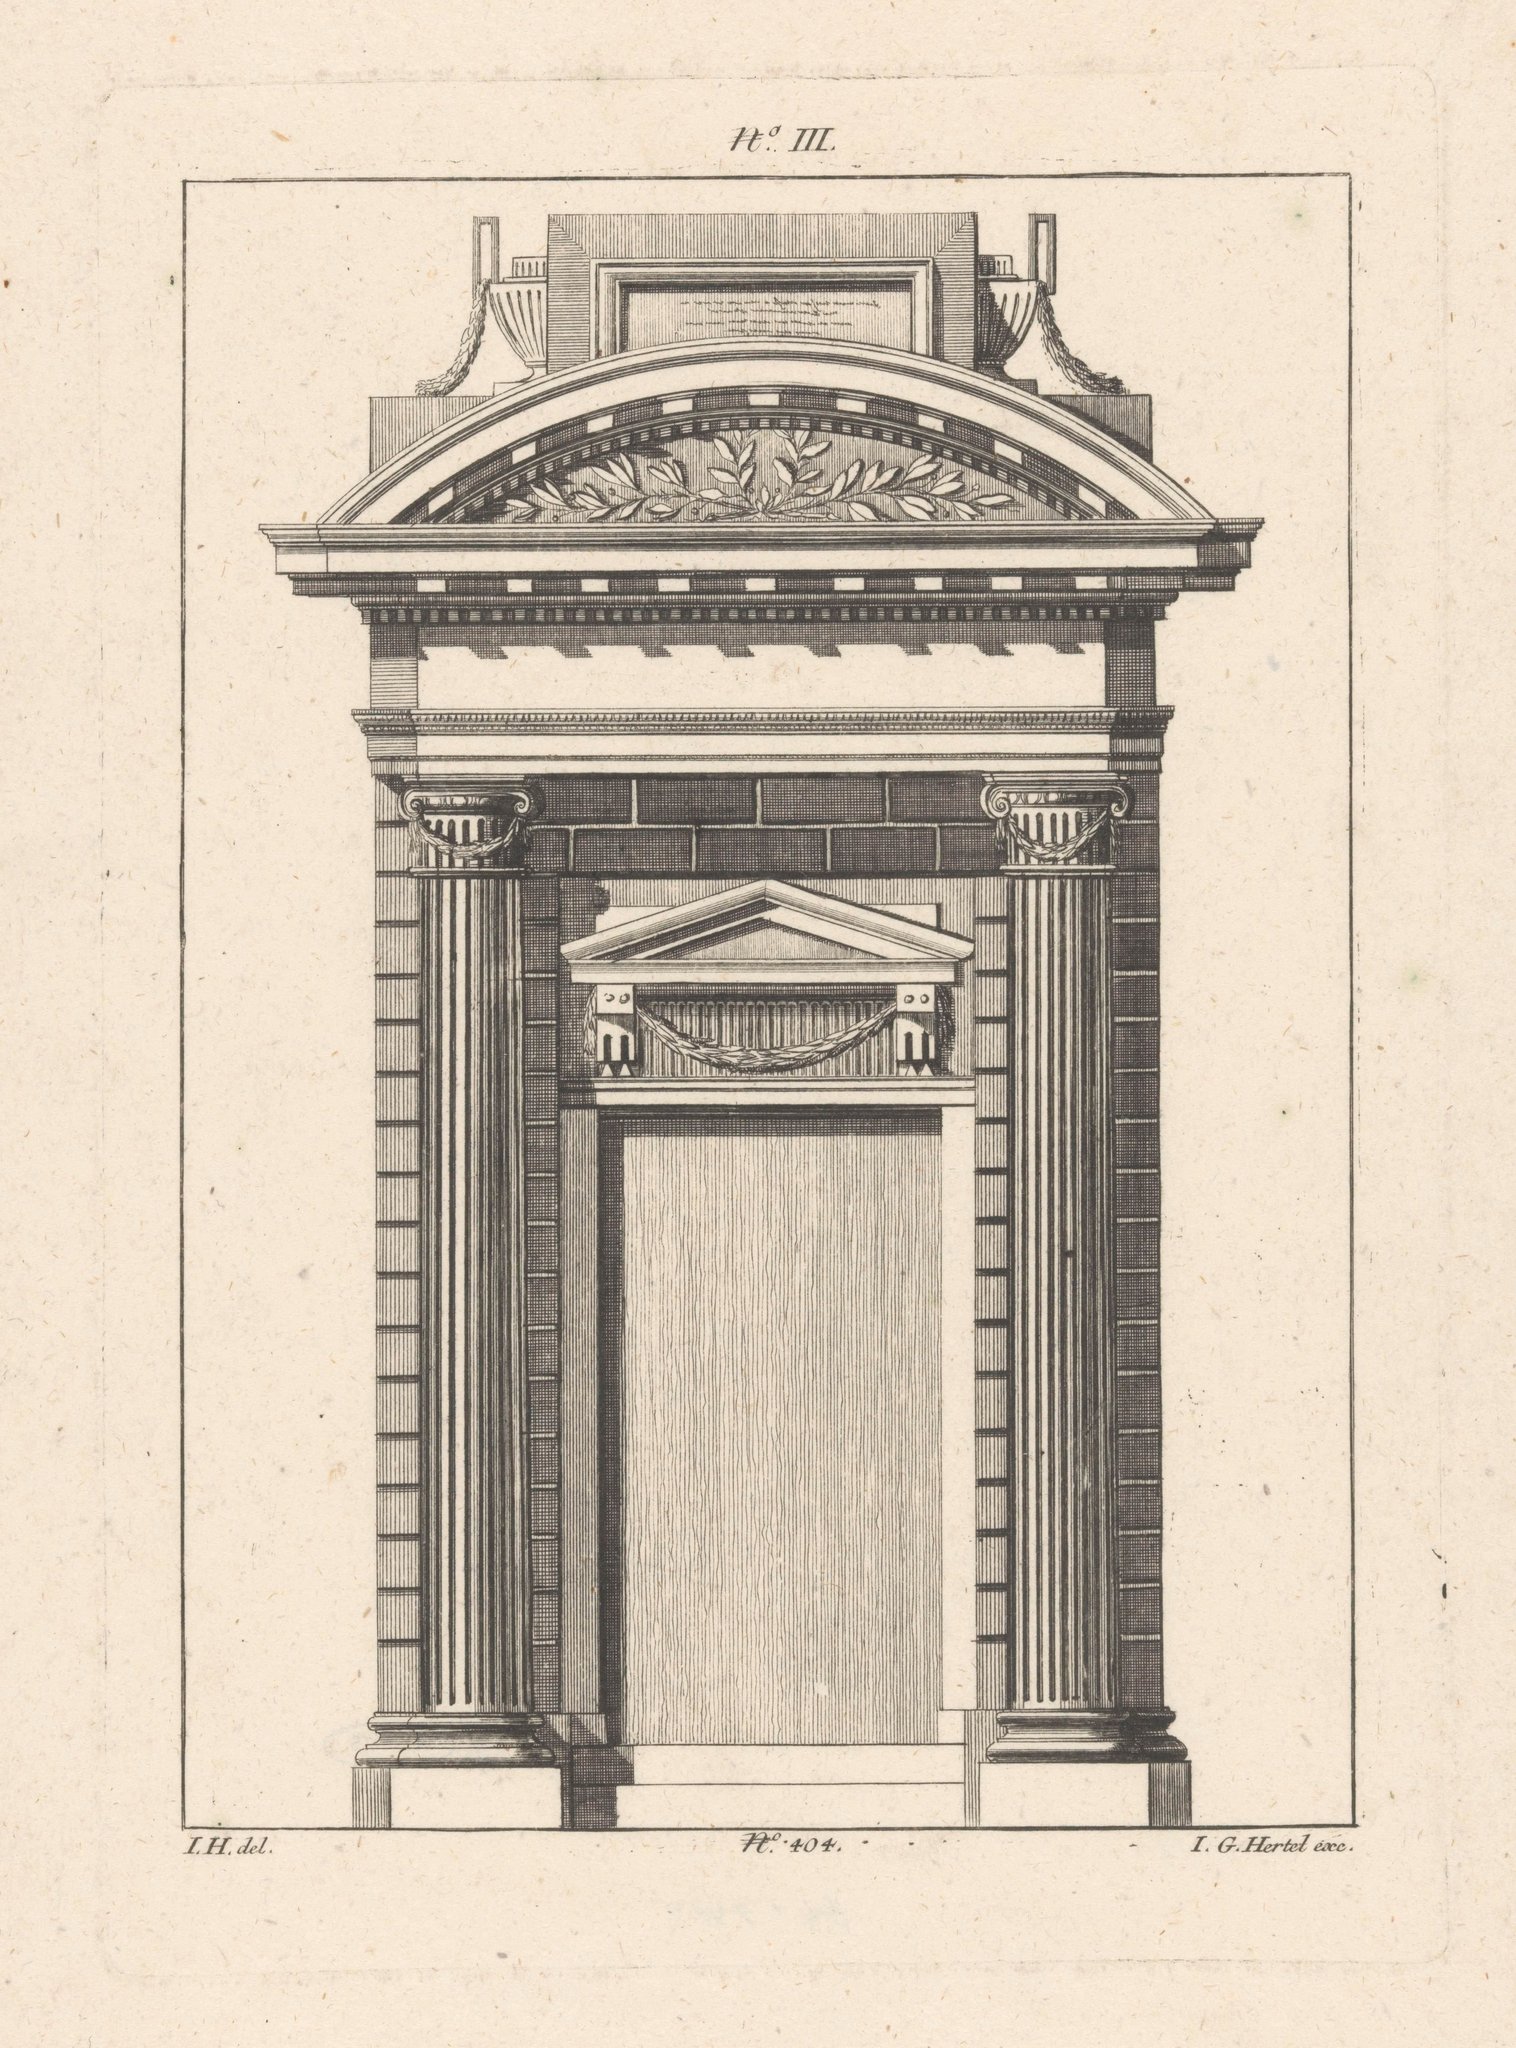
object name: ornament print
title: Portalen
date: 1770-1778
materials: paper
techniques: engraving, etching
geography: augsburg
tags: monumental door, porch, 'aediculum'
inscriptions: collector's mark: Lugt 2228, collector's mark: Lugt 2760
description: Ontwerp voor een portaal met twee pilasters en een segmentvormig fronton met olijftakken. Aan weerszijden bekroond met vazen. Uitgeversnummer 404.